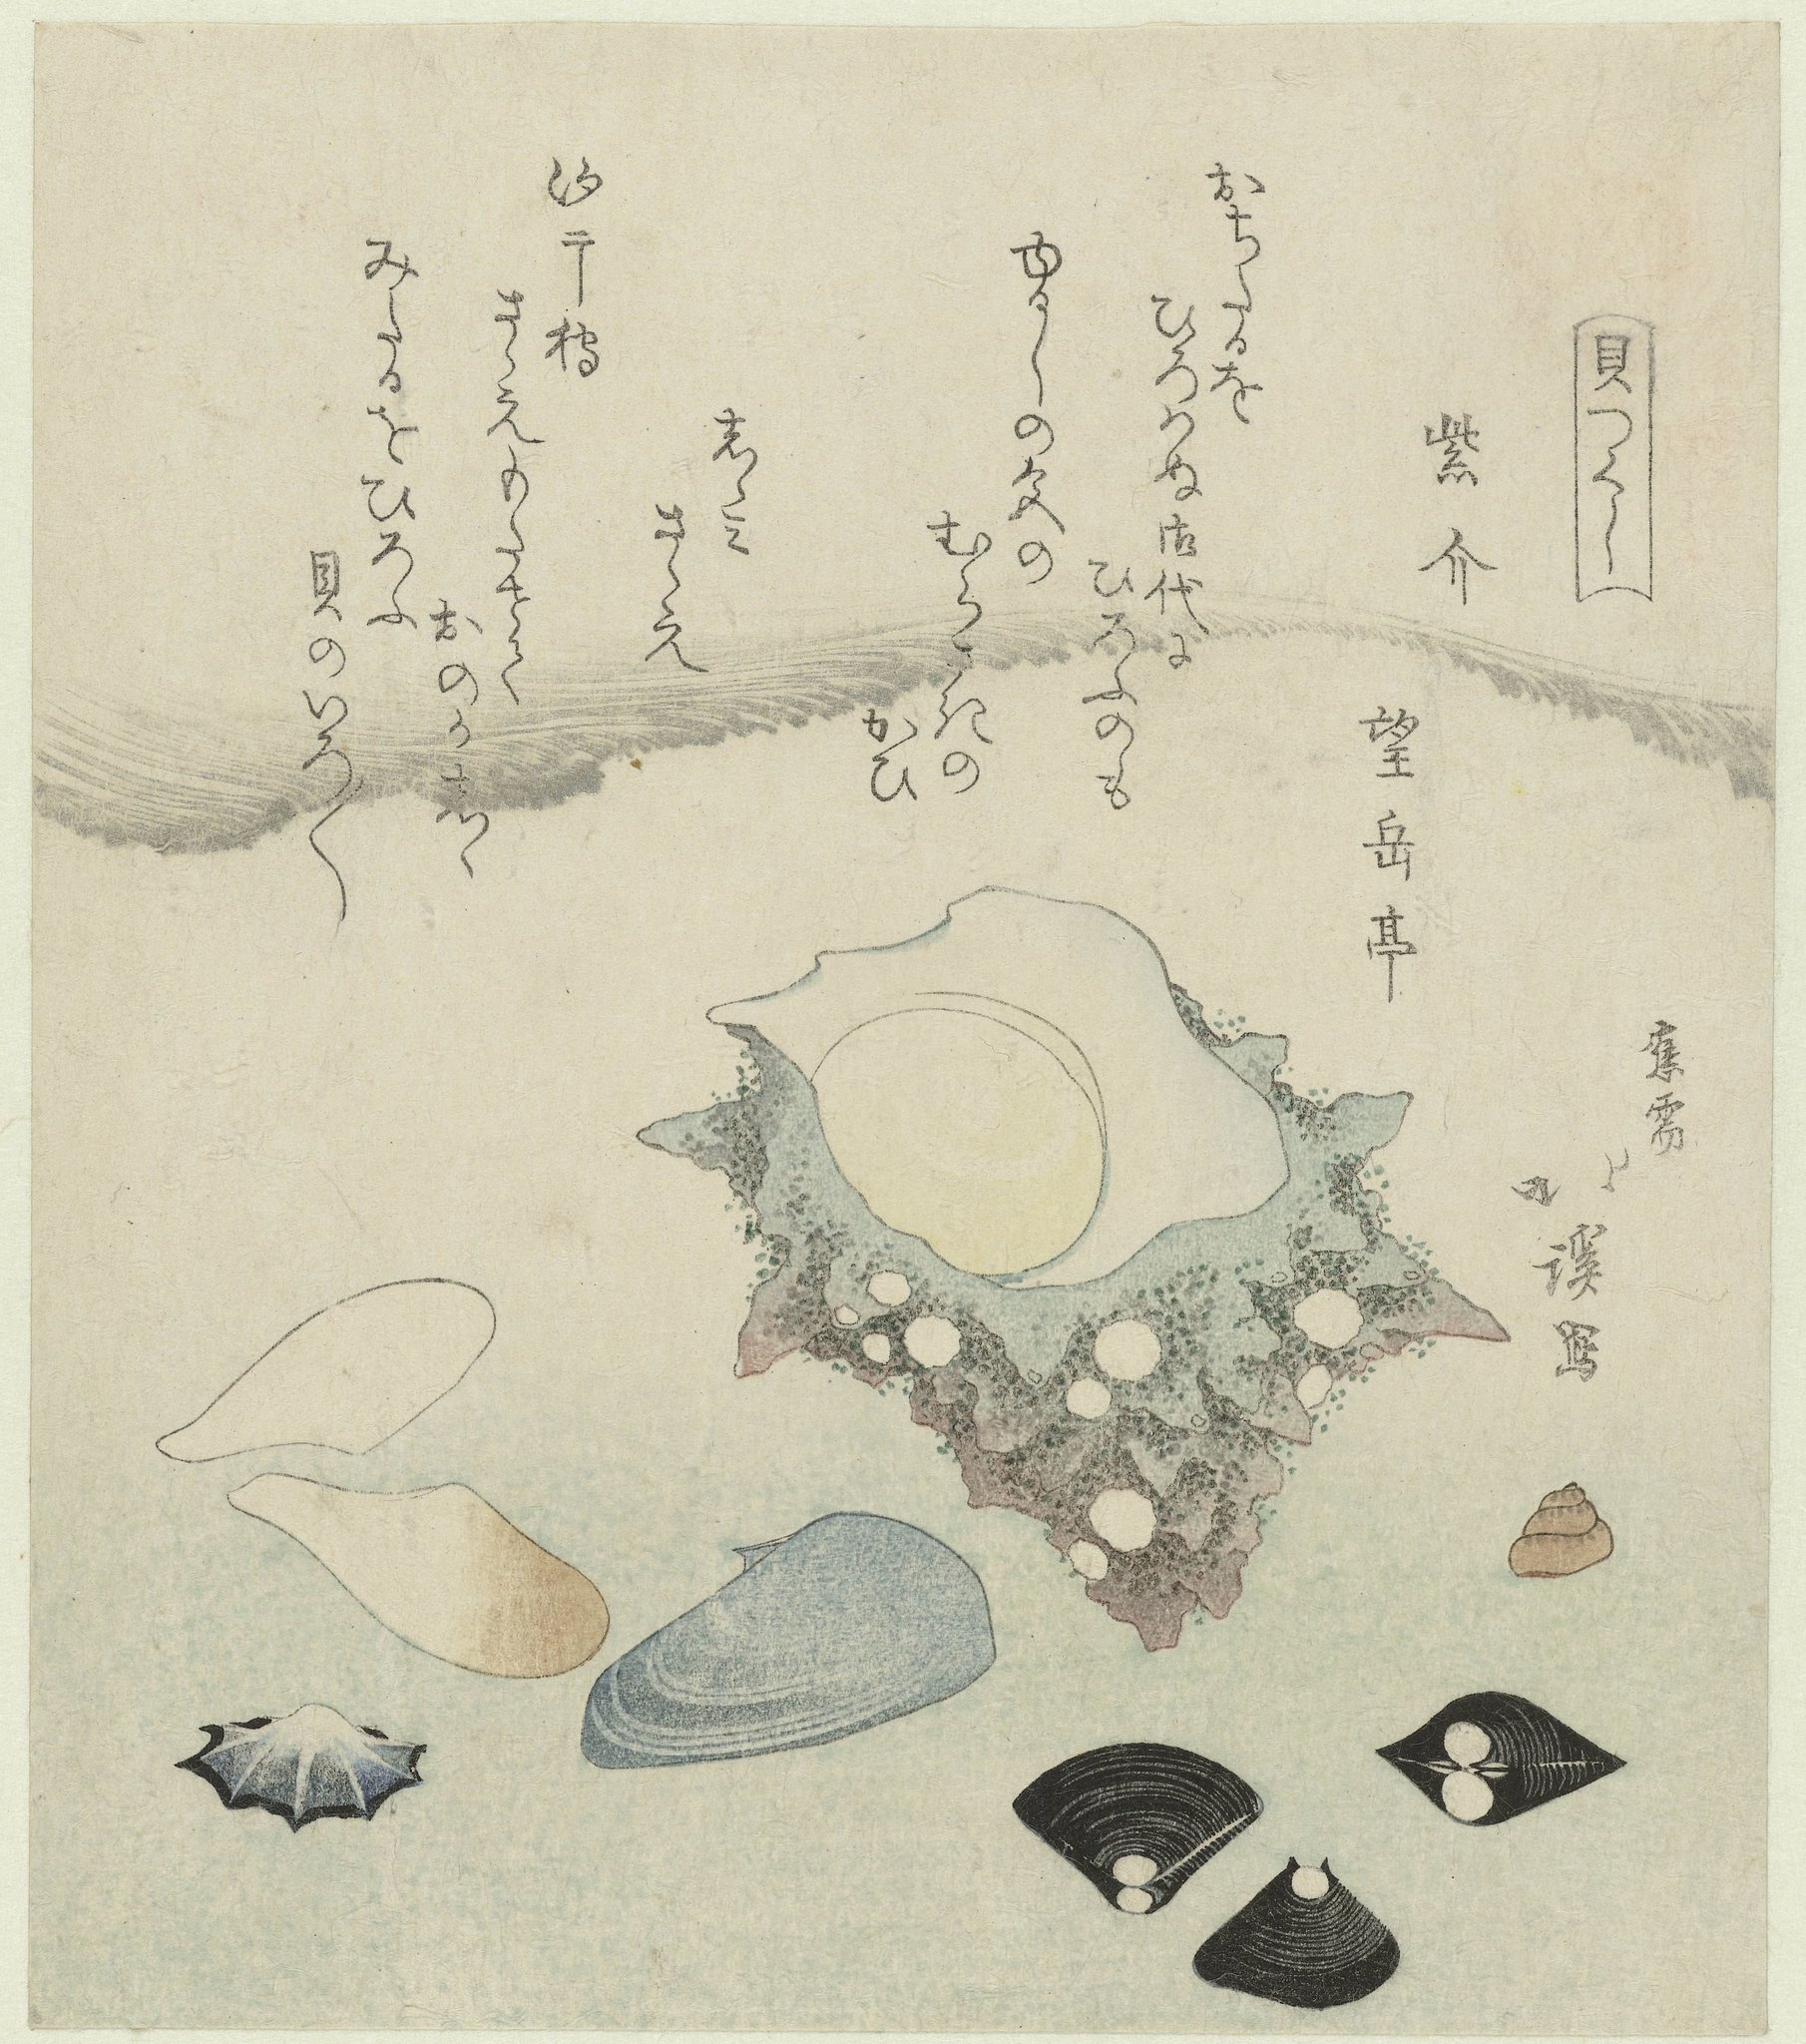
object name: surimono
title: Kaitsukushi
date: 1821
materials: paper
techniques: blind stamped, woodcut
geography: japan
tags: molluscs (+ shell, snail-shell etc.)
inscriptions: collector's mark, passe-partout, bottom left, printed: JABdH with a rooster., collector's mark, verso, stamped: Lugt 2228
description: Een surimono is een luxe uitgevoerde prent waarop beeld met één of meerdere gedichten gecombineerd is. Bij het drukken van een surimono werd vaak gebruik gemaakt van dikker papier, blinddruk en metaal pigmenten, zoals koper- en zilverpoeder. De prenten werden vaak in opdracht van dichters gemaakt en als exclusief geschenk aan vrienden en relaties gegeven.